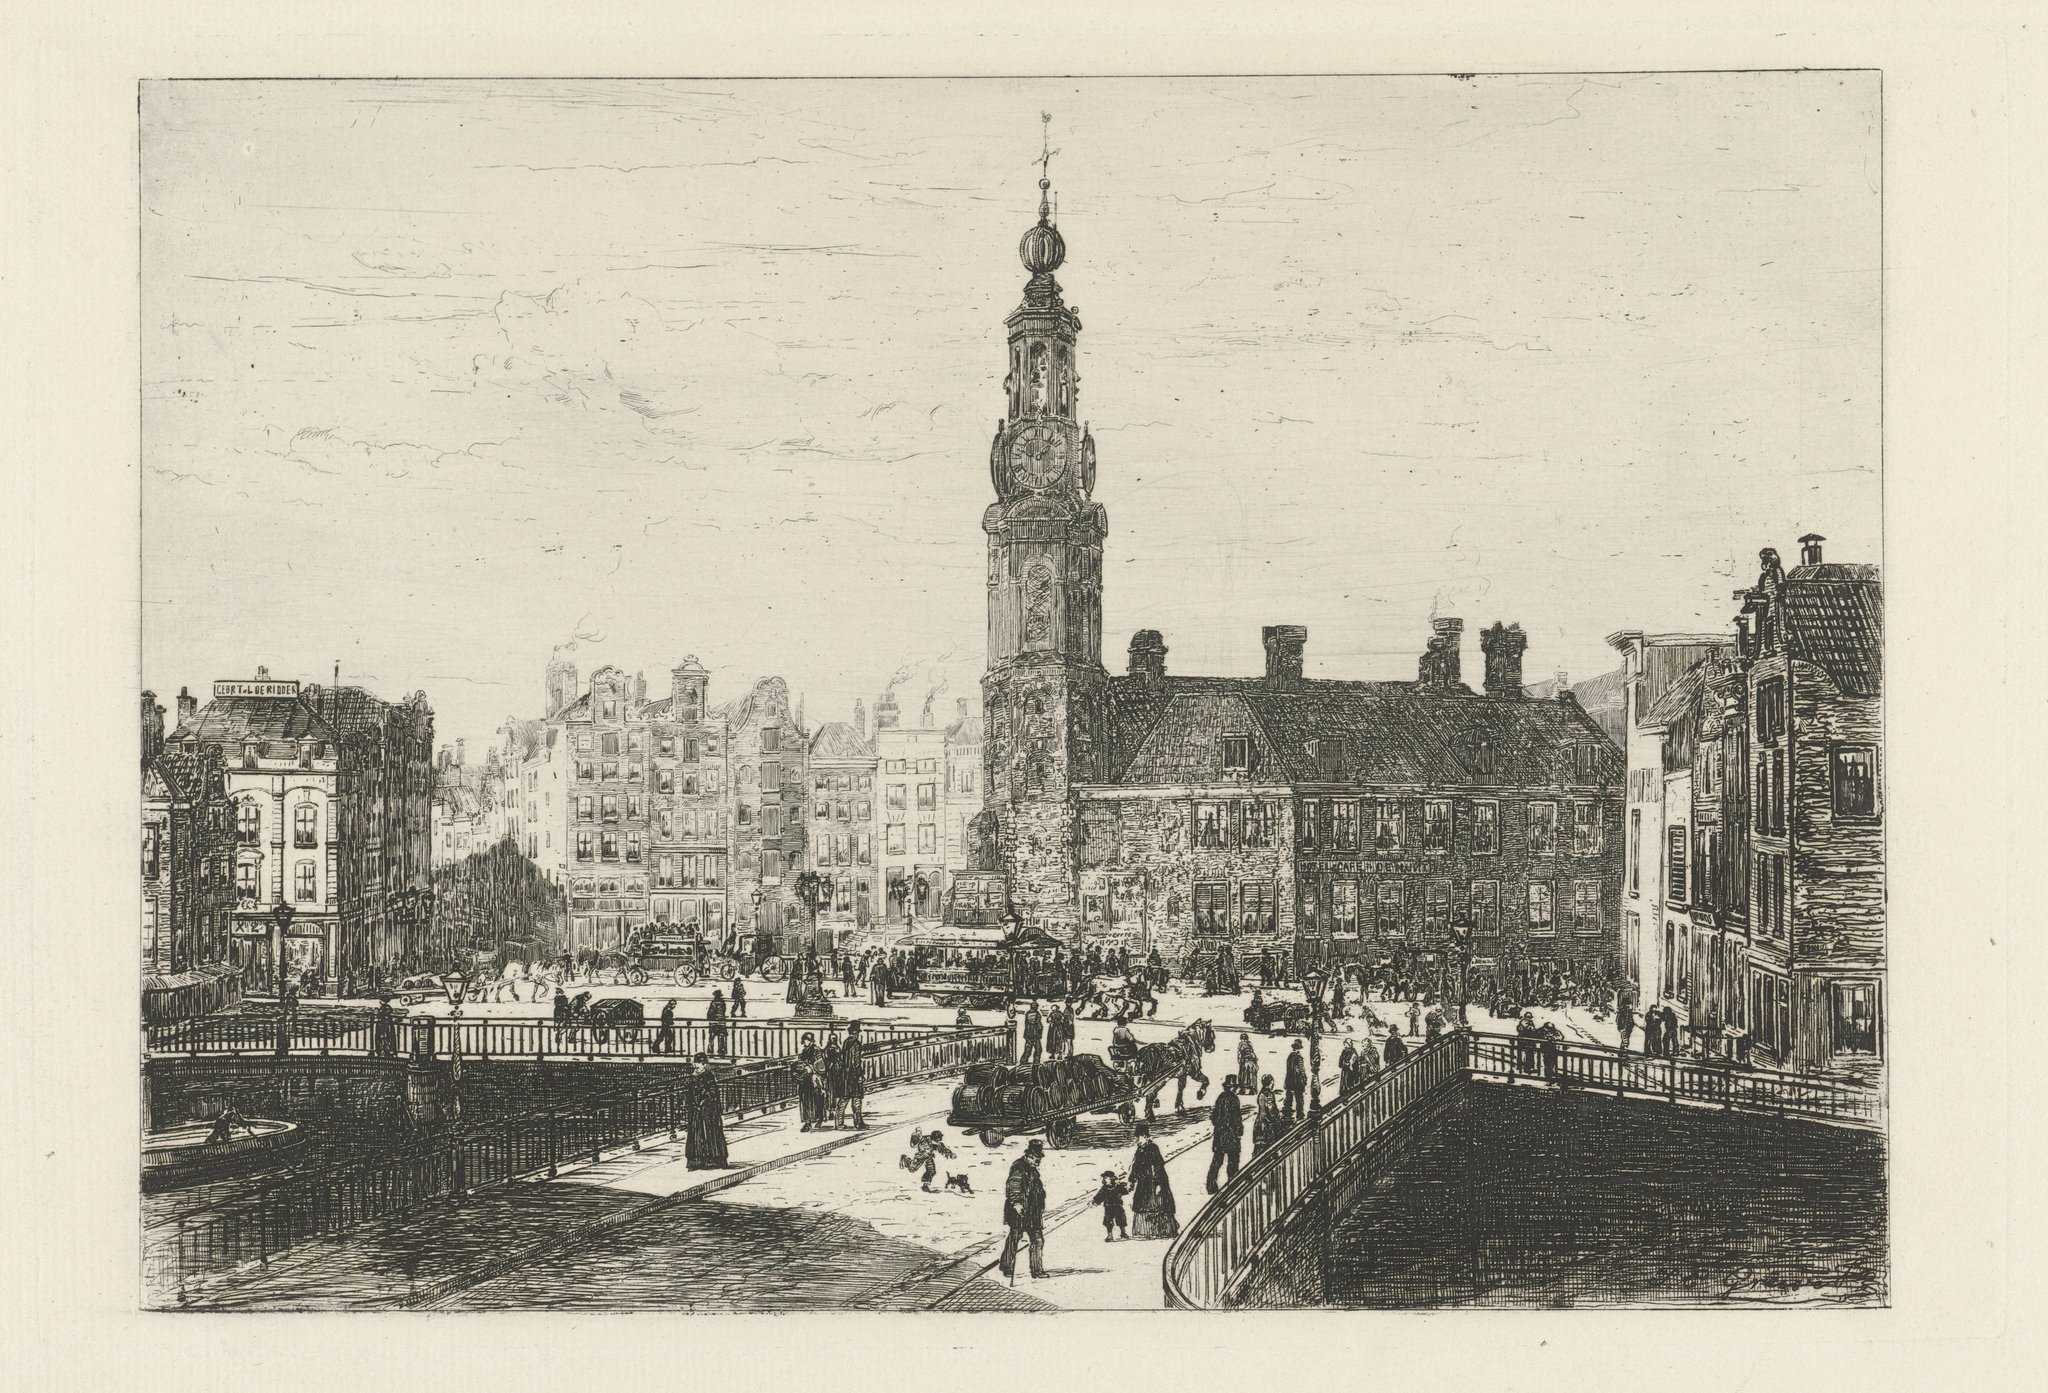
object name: print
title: Gezicht op het Muntplein van Amsterdam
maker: johan conrad greive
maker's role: draughtsman, painter, print maker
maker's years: 1837-1891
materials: paper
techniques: etching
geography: amsterdam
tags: street, amsterdam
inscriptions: collector's mark: Lugt 2228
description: Gezicht op het Muntplein van Amsterdam met in het midden de Munt.